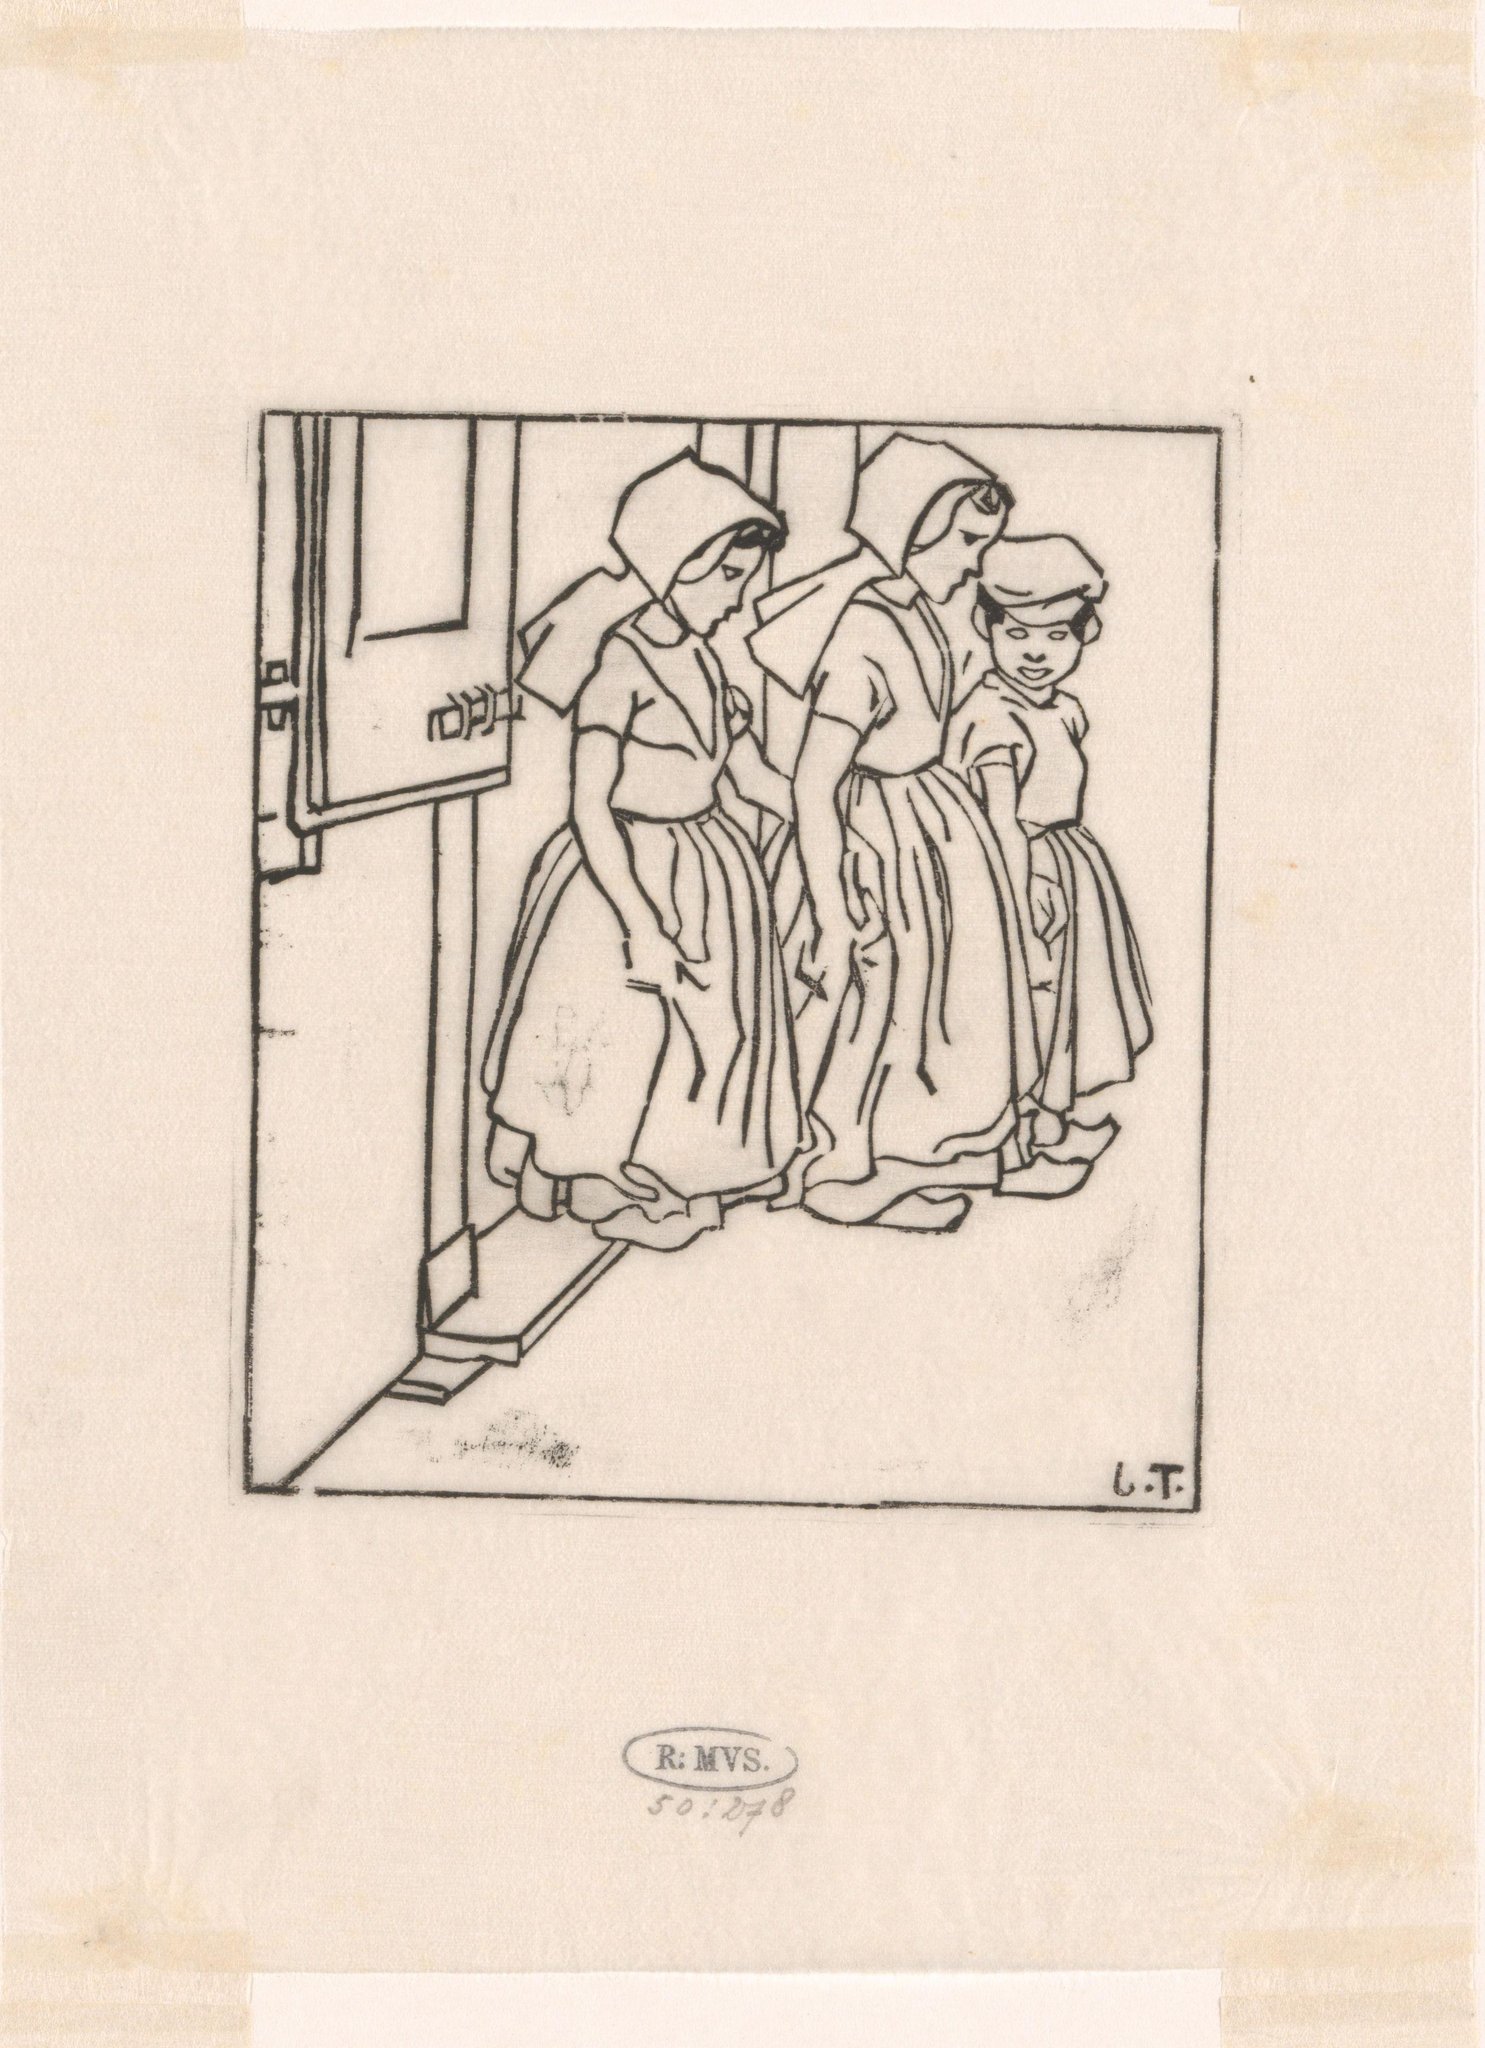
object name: print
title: Drie Zeeuwse kinderen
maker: jan toorop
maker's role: draughtsman, painter, print maker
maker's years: 1858-1928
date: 1903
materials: paper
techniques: woodcut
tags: child (at home)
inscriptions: collector's mark: Lugt 2228